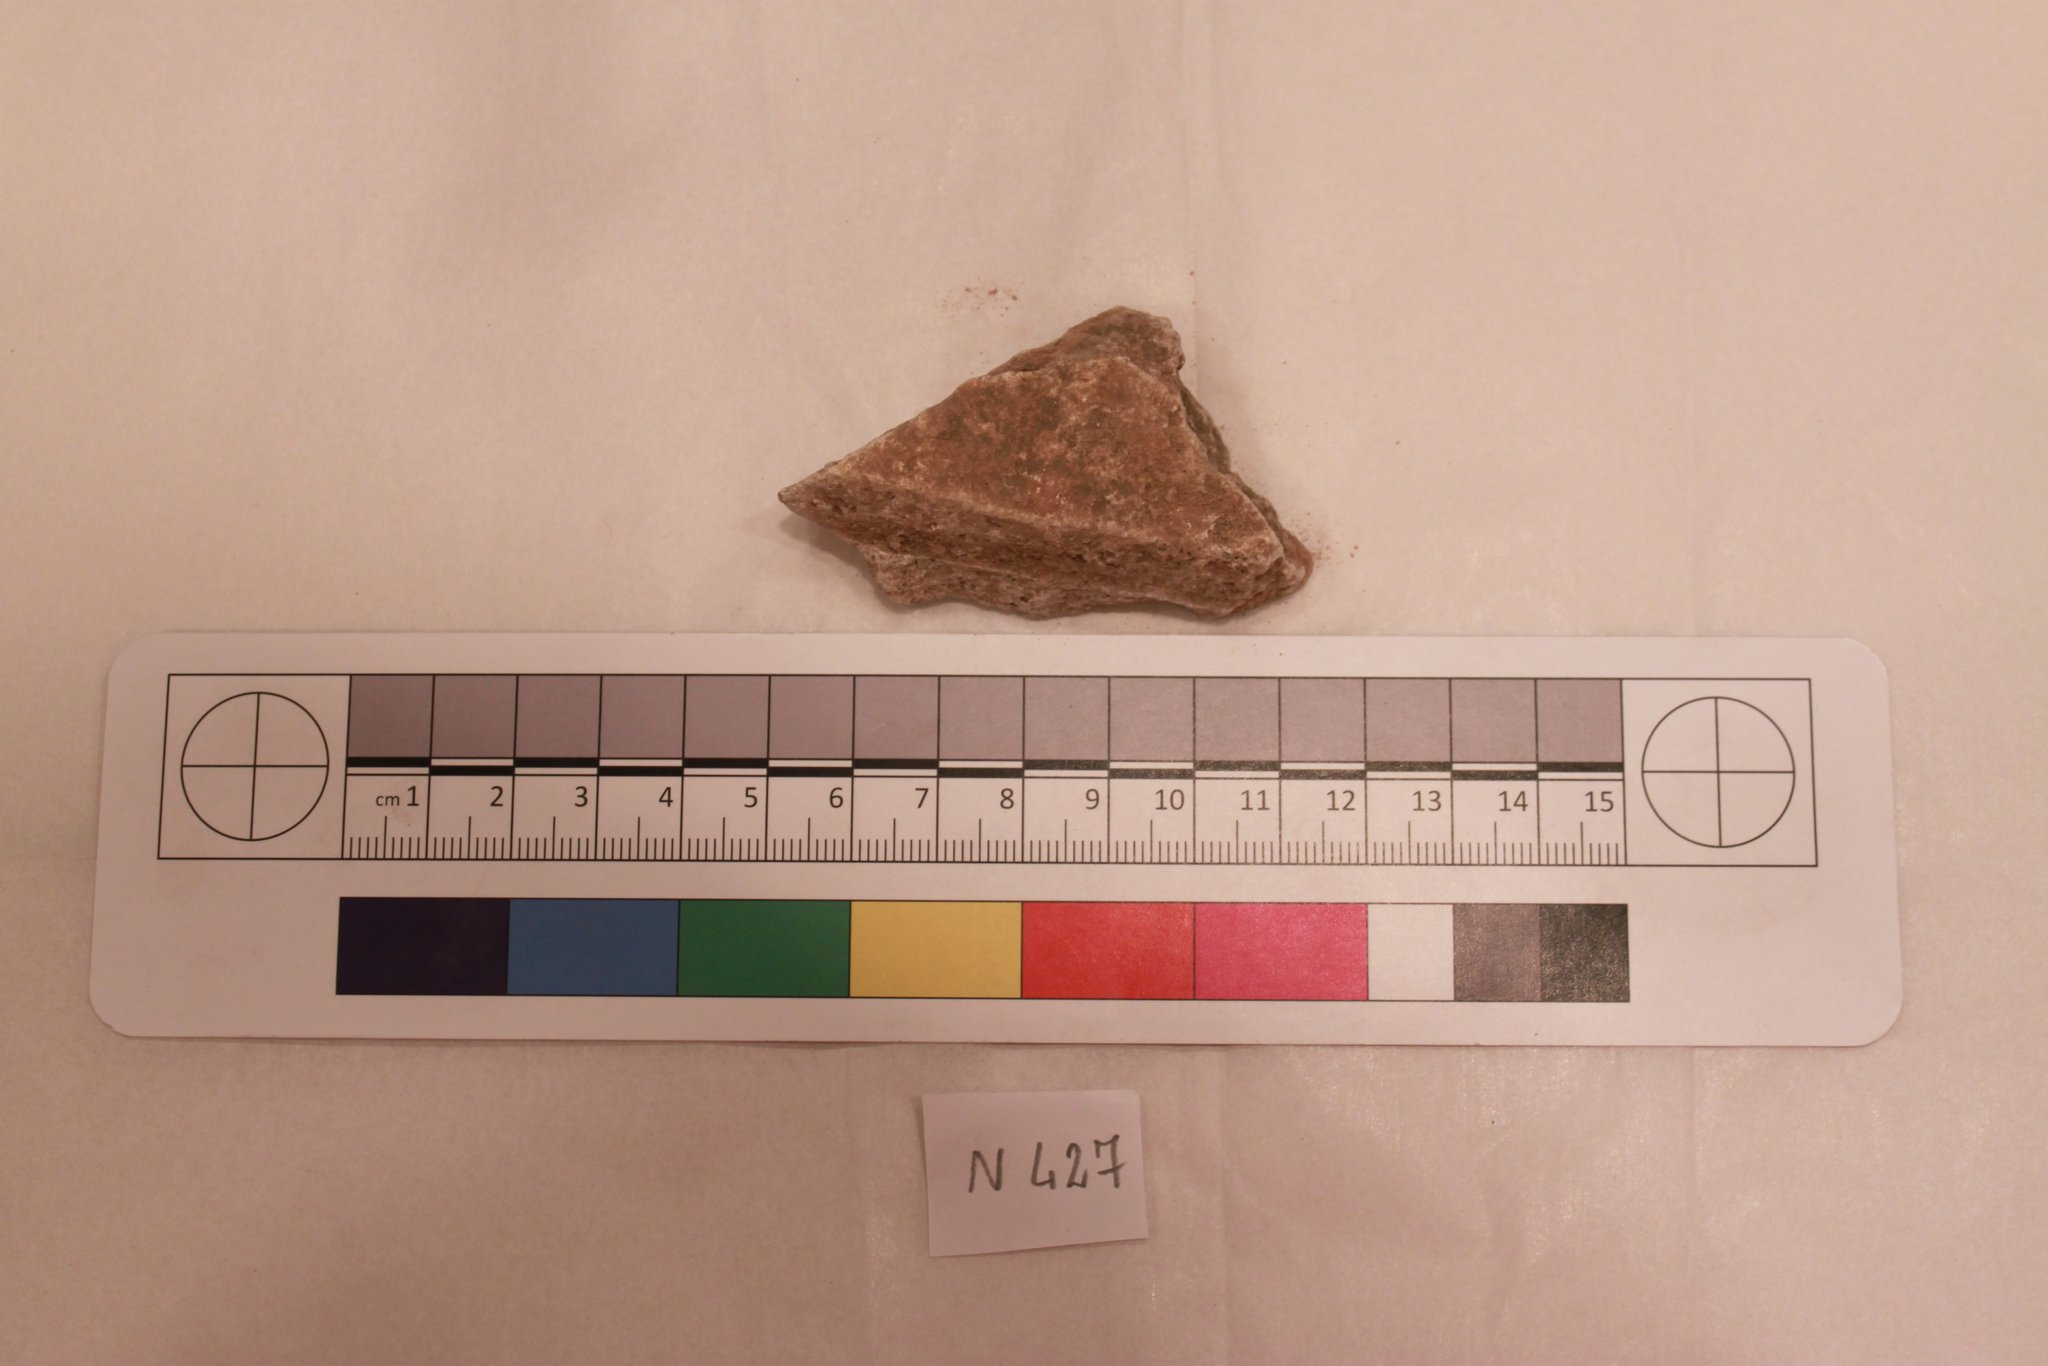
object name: fragment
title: Stucco Fragment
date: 701-1200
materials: plaster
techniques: carving, painting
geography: iran